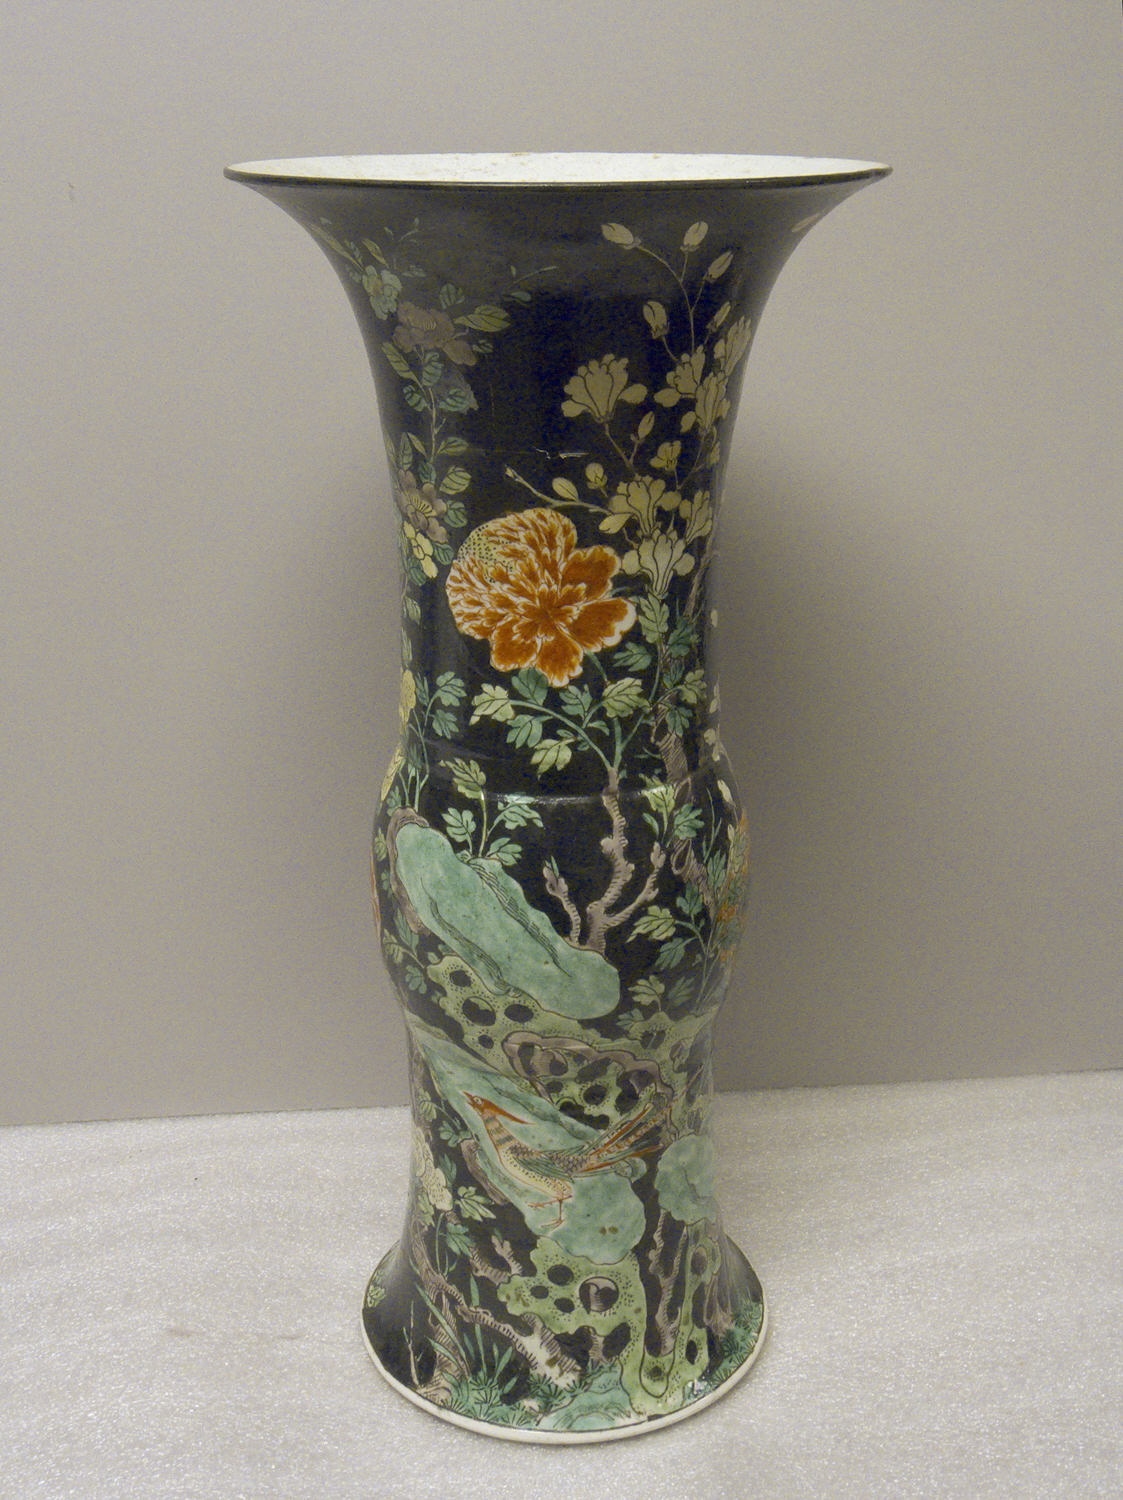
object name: vase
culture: chinese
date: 1662-1722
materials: porcelain